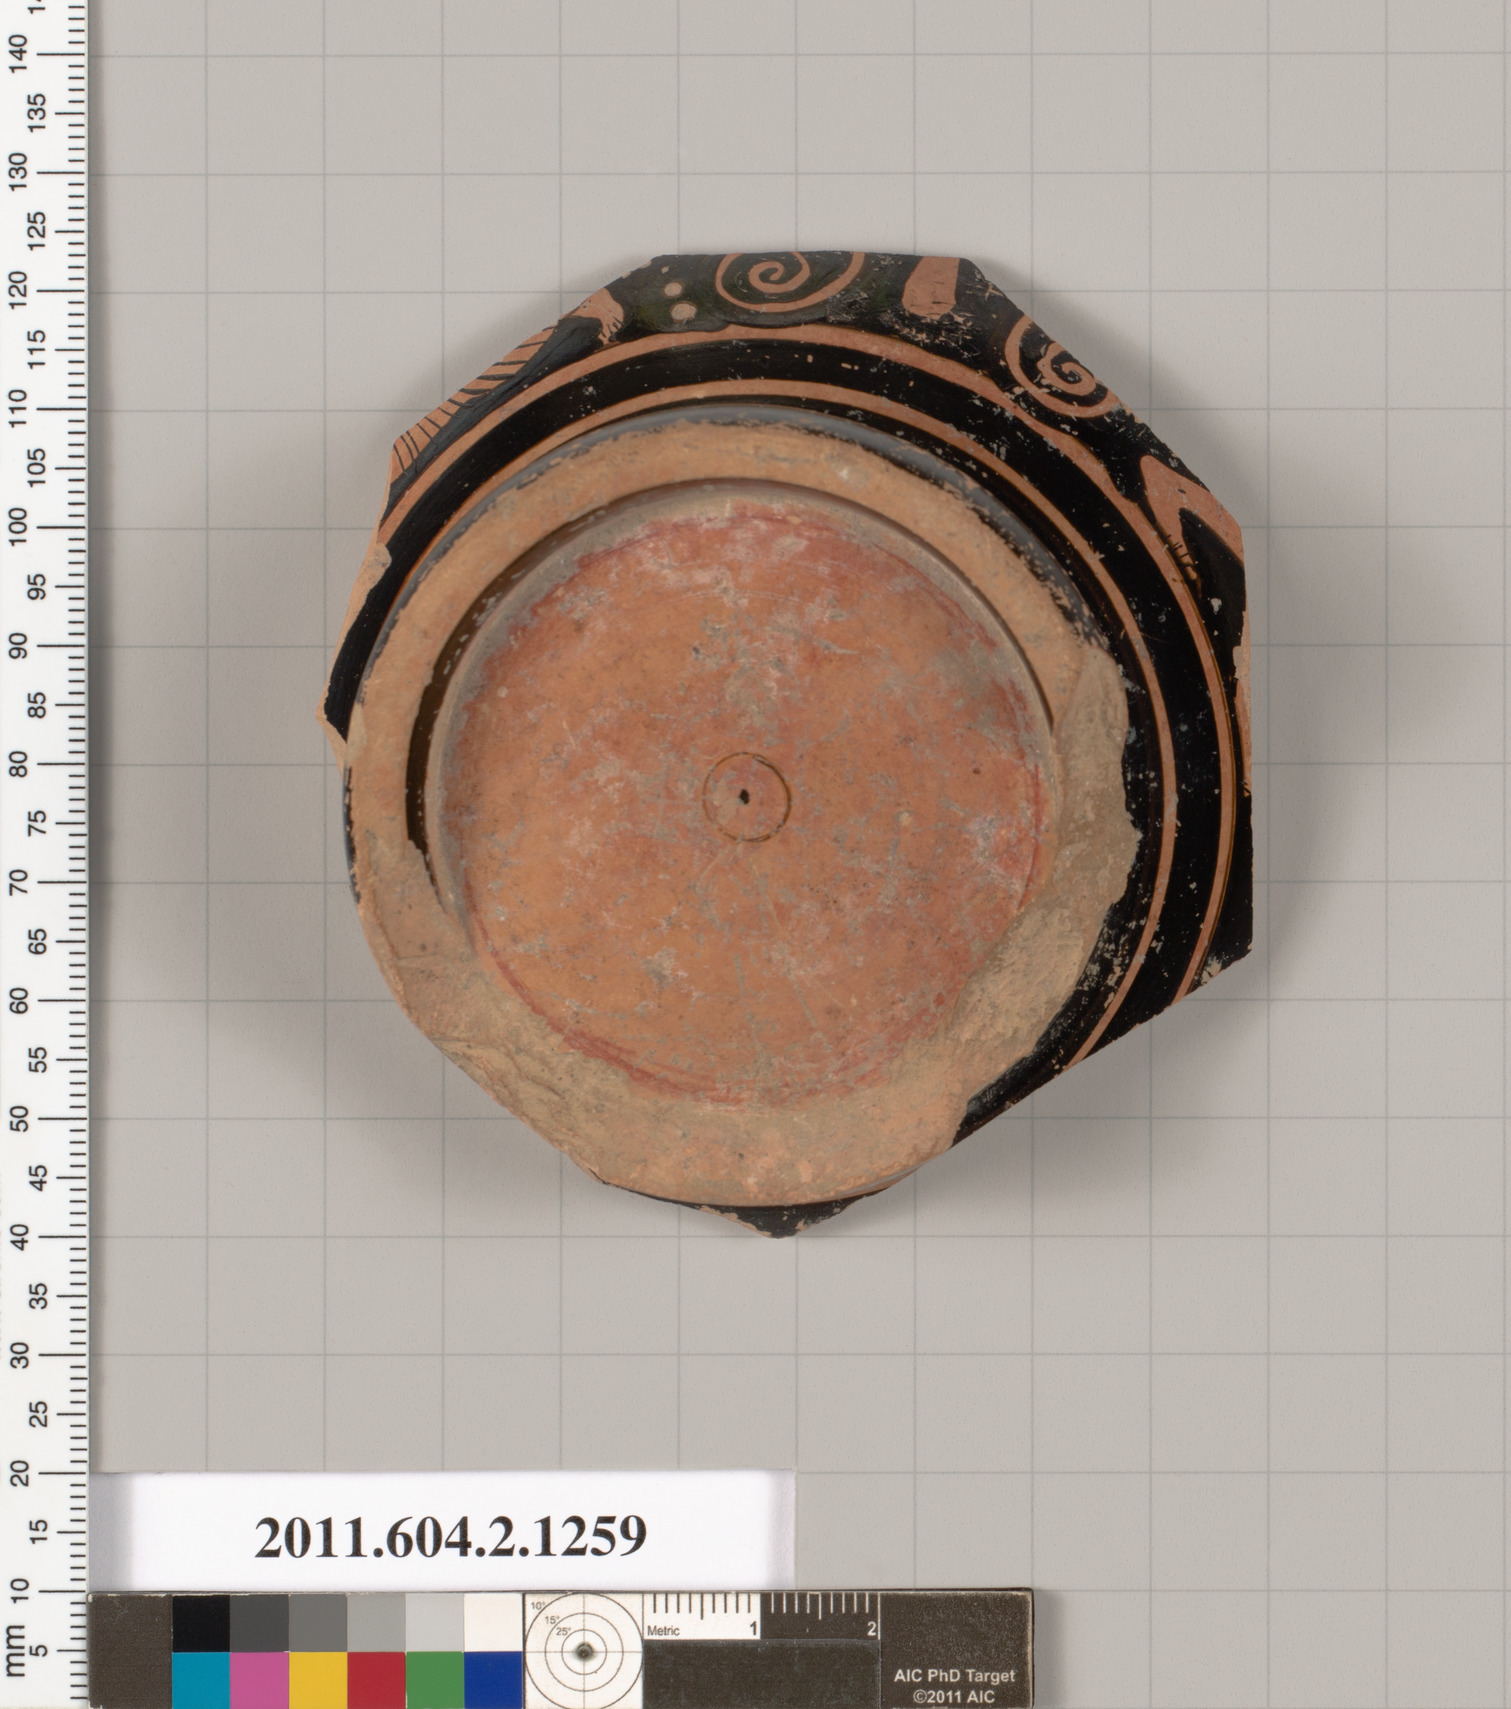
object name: skyphos fragment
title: Terracotta fragment of a skyphos (deep drinking cup)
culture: greek, attic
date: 450-440 BCE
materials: terracotta